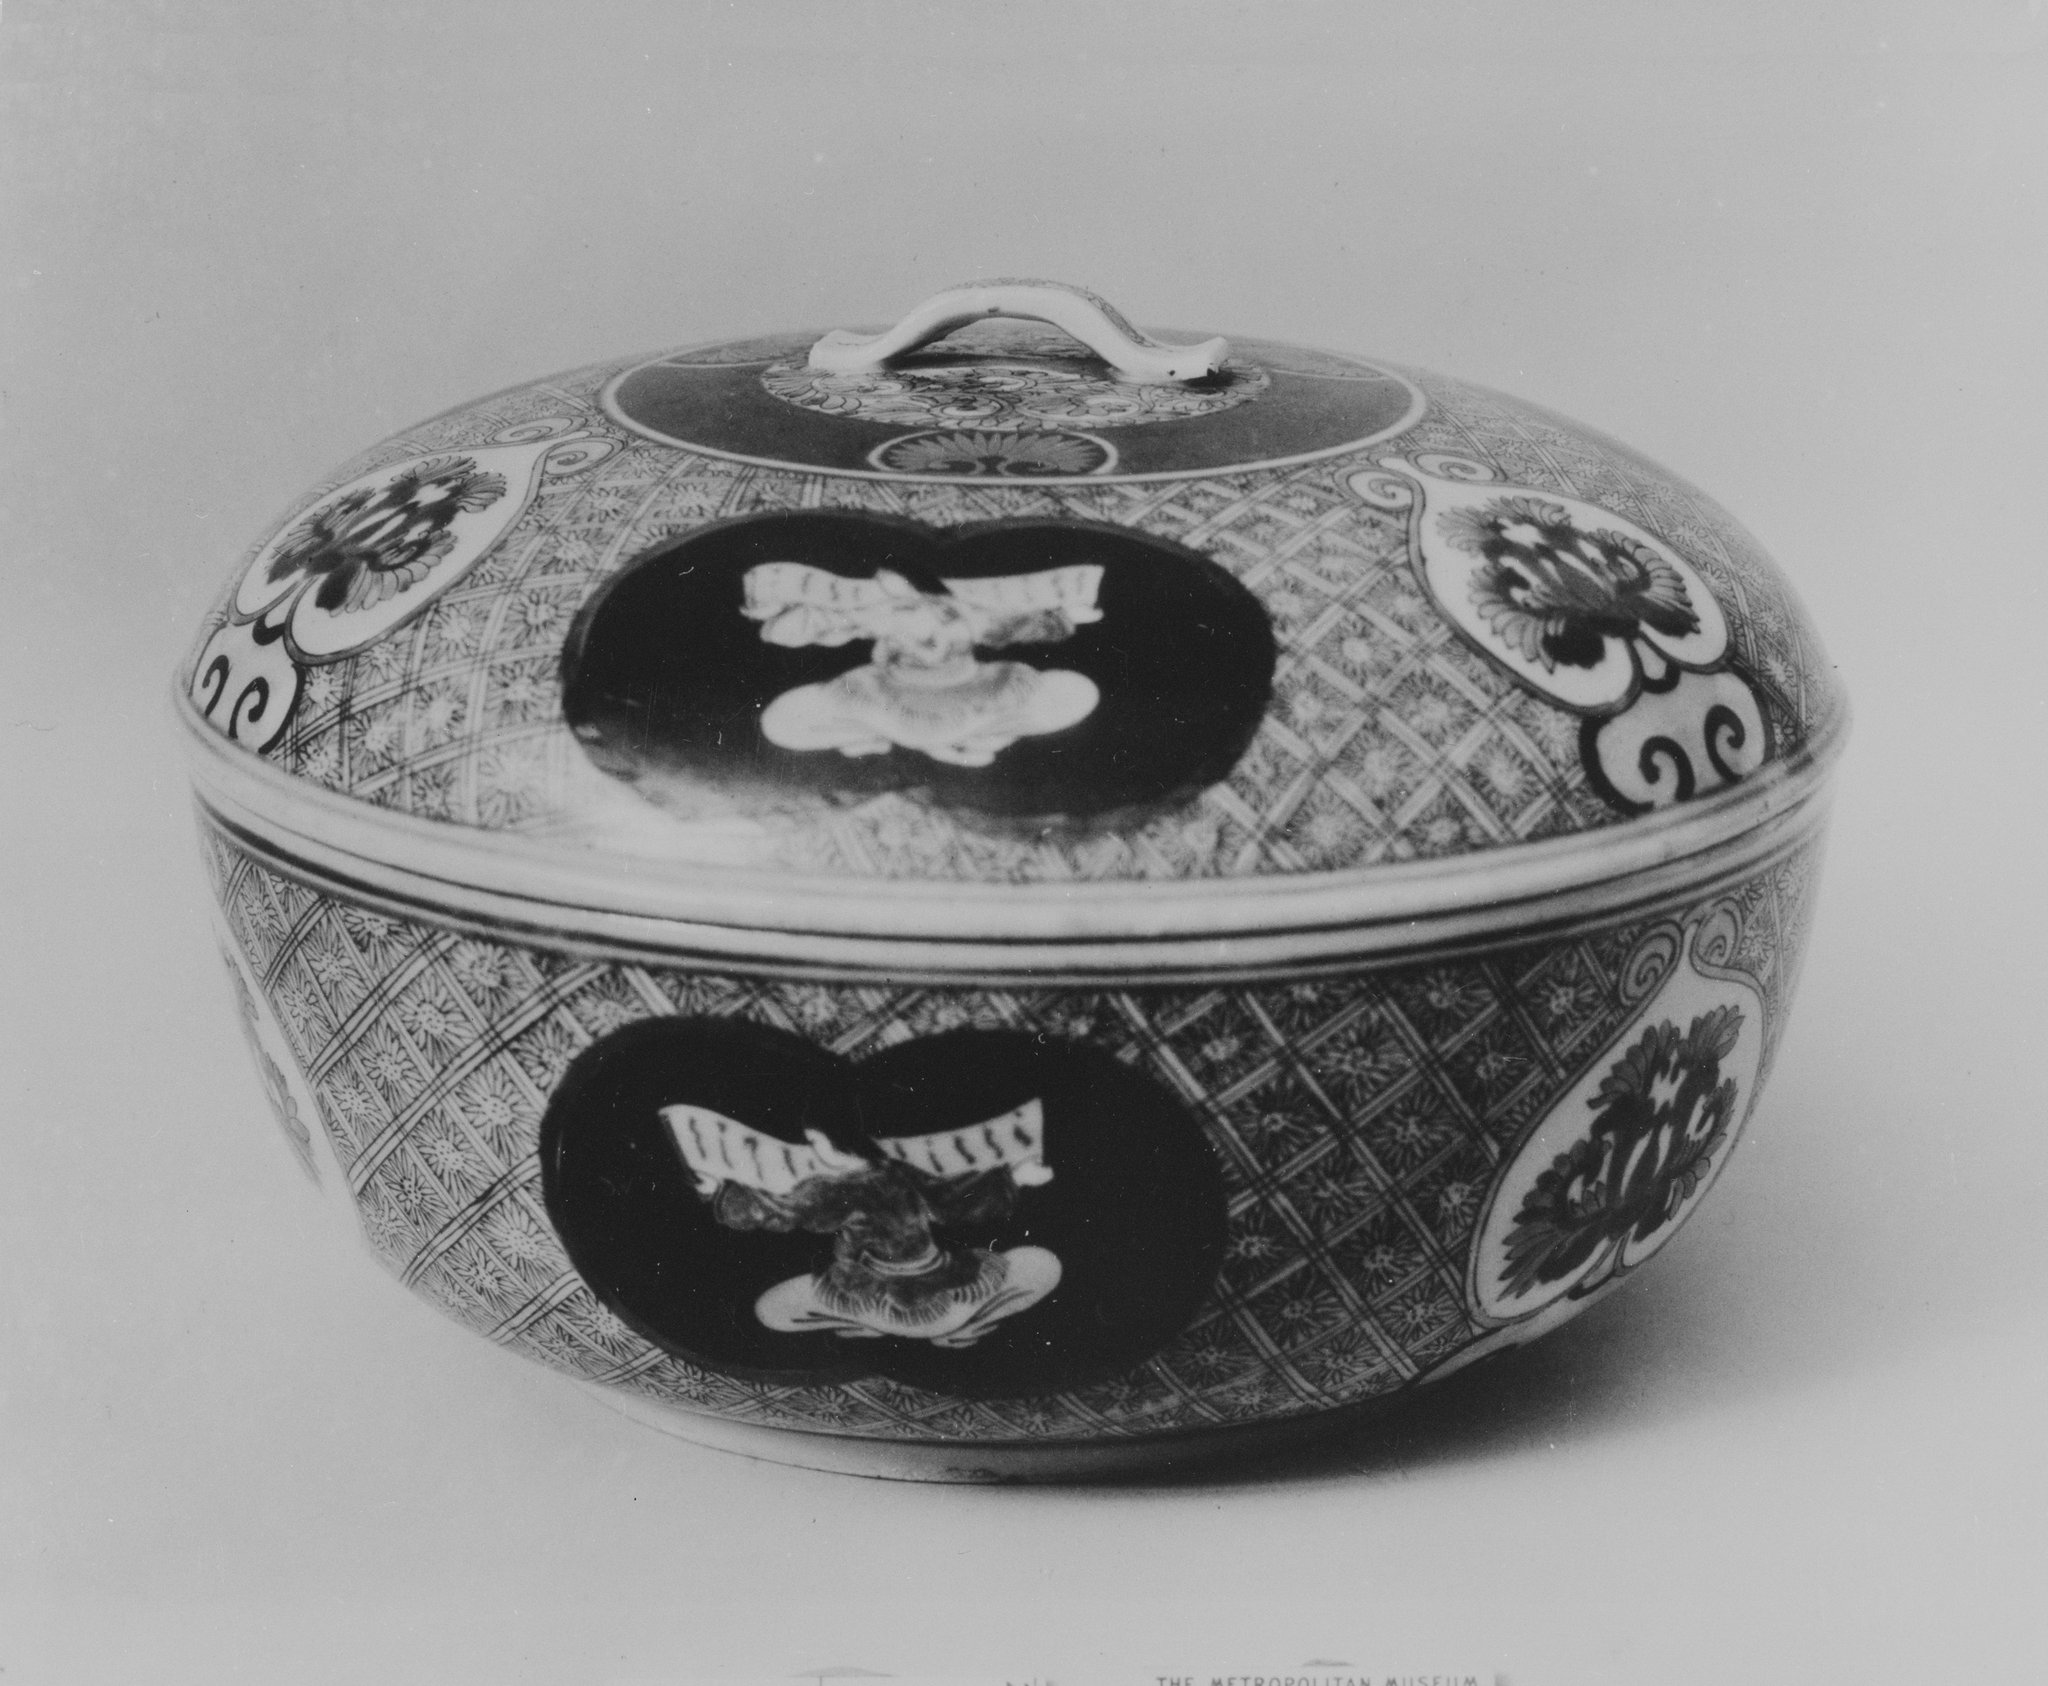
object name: covered bowl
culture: japanese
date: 1750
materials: enamel, porcelain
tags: flowers